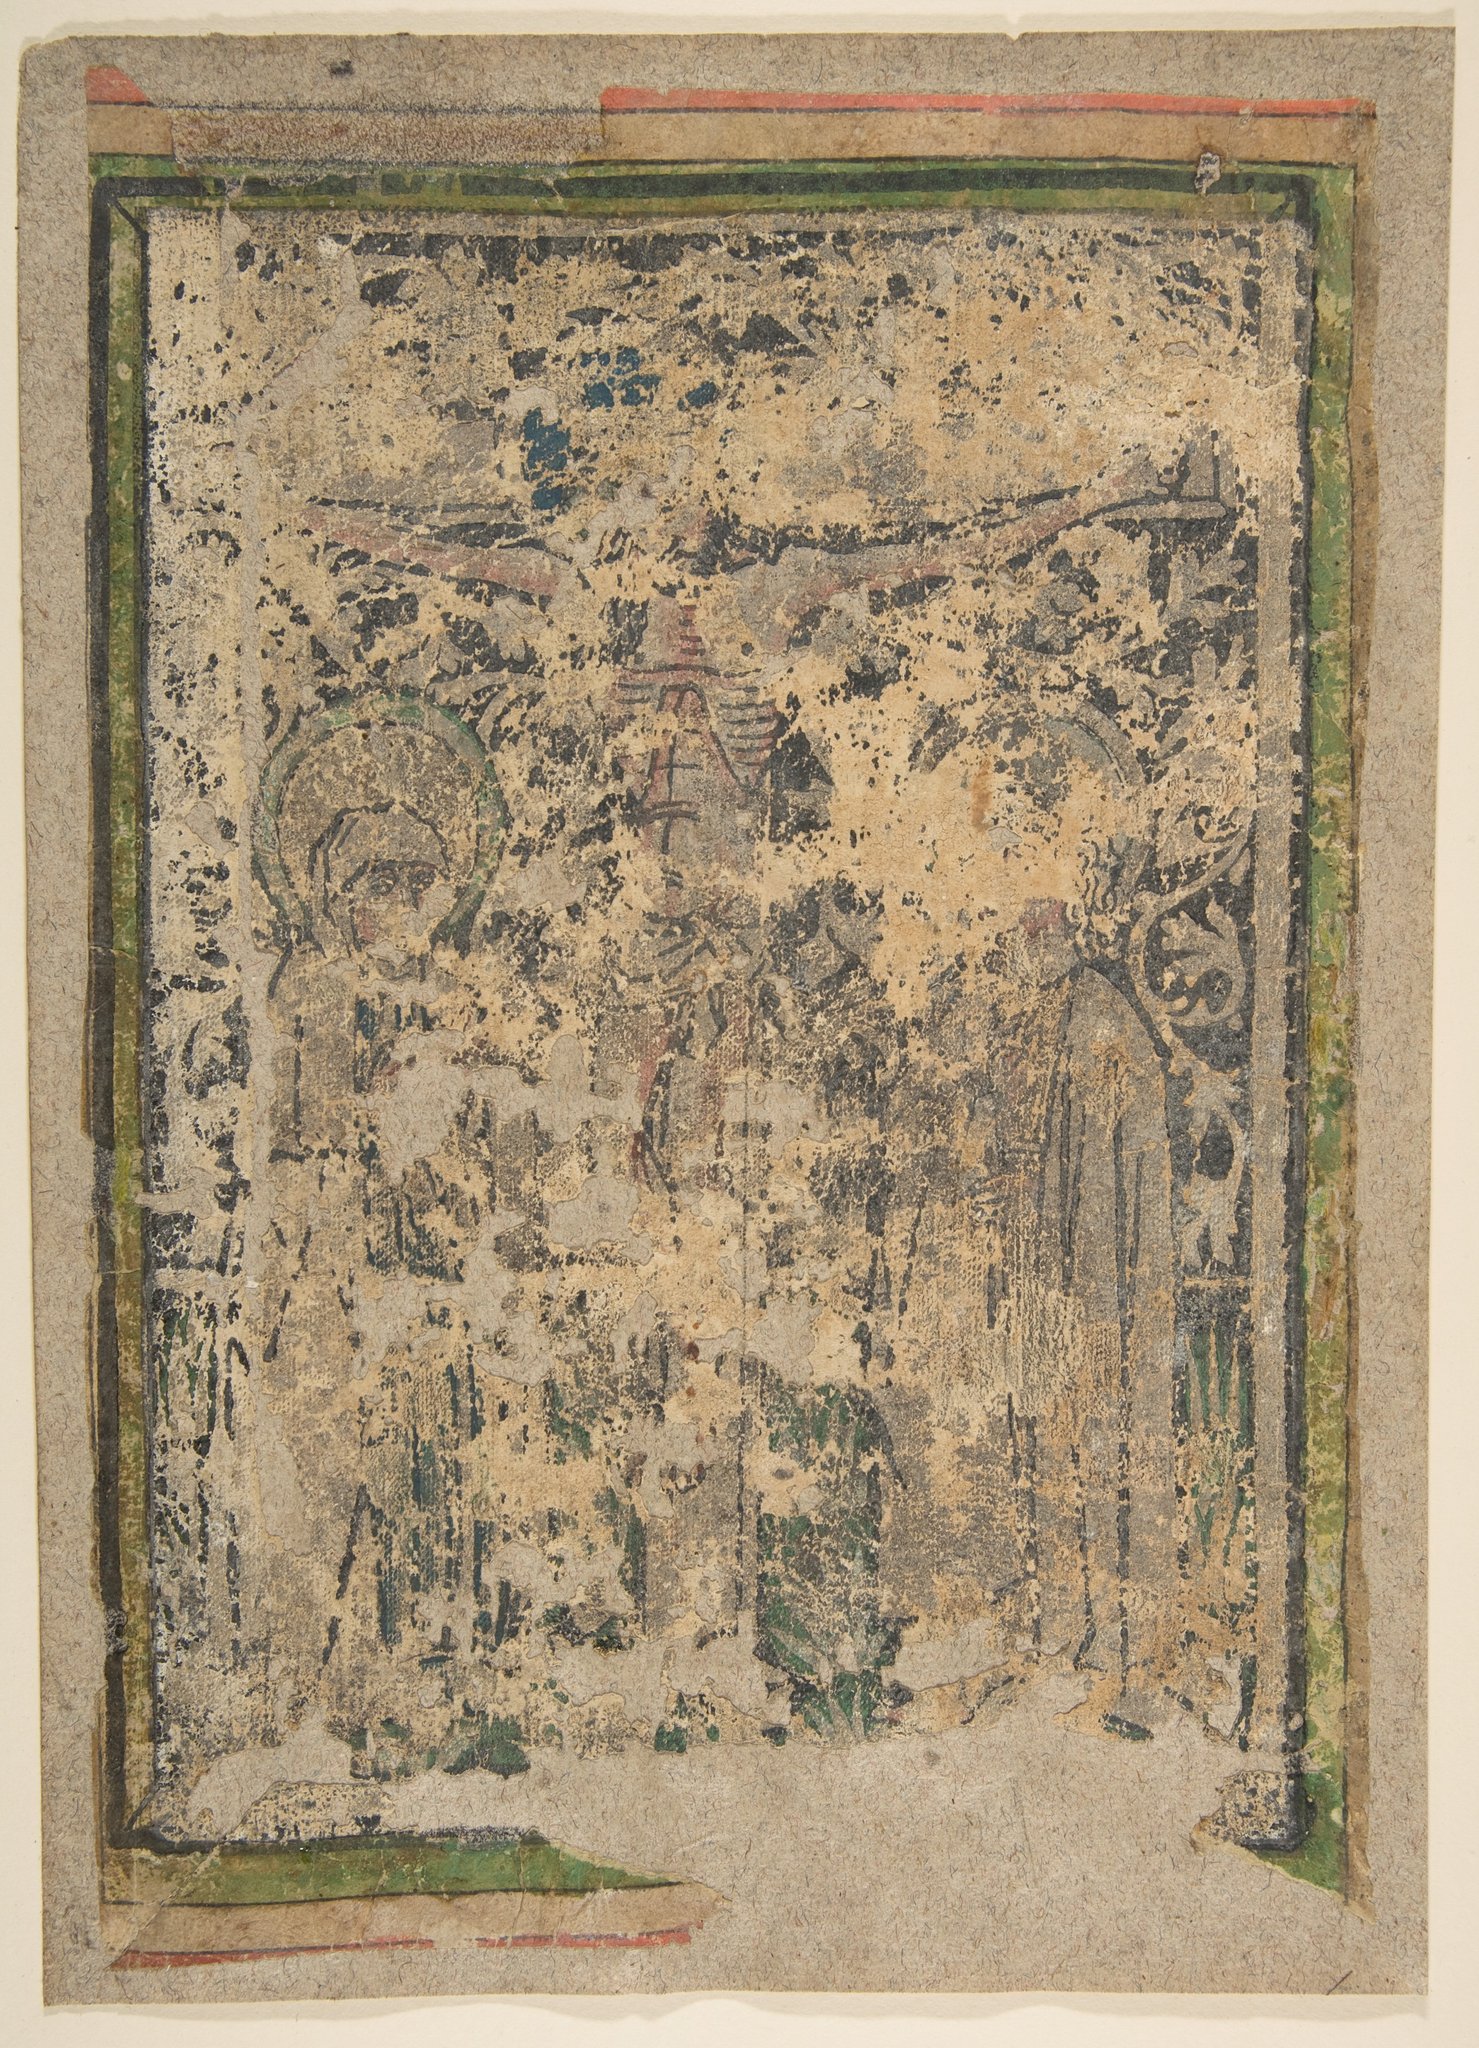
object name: print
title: Christ on the Cross (Schr. 2789a)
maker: anonymous, german, 15th century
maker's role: artist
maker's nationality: german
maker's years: 1400-1500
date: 1401-1500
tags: christ,cross,crucifixion